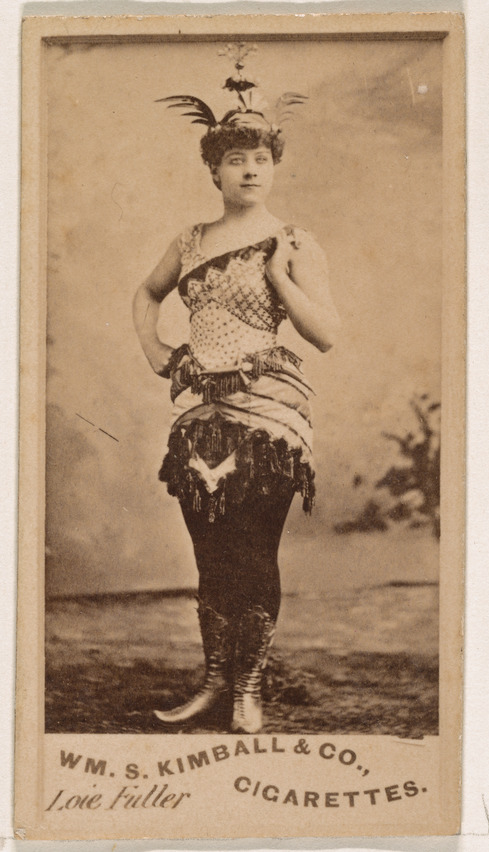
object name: photograph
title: Loie Fuller, from the Actresses series (N203) issued by Wm. S. Kimball & Co.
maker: william s. kimball & company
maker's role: publisher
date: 1889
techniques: color lithograph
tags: portraits,women,actresses